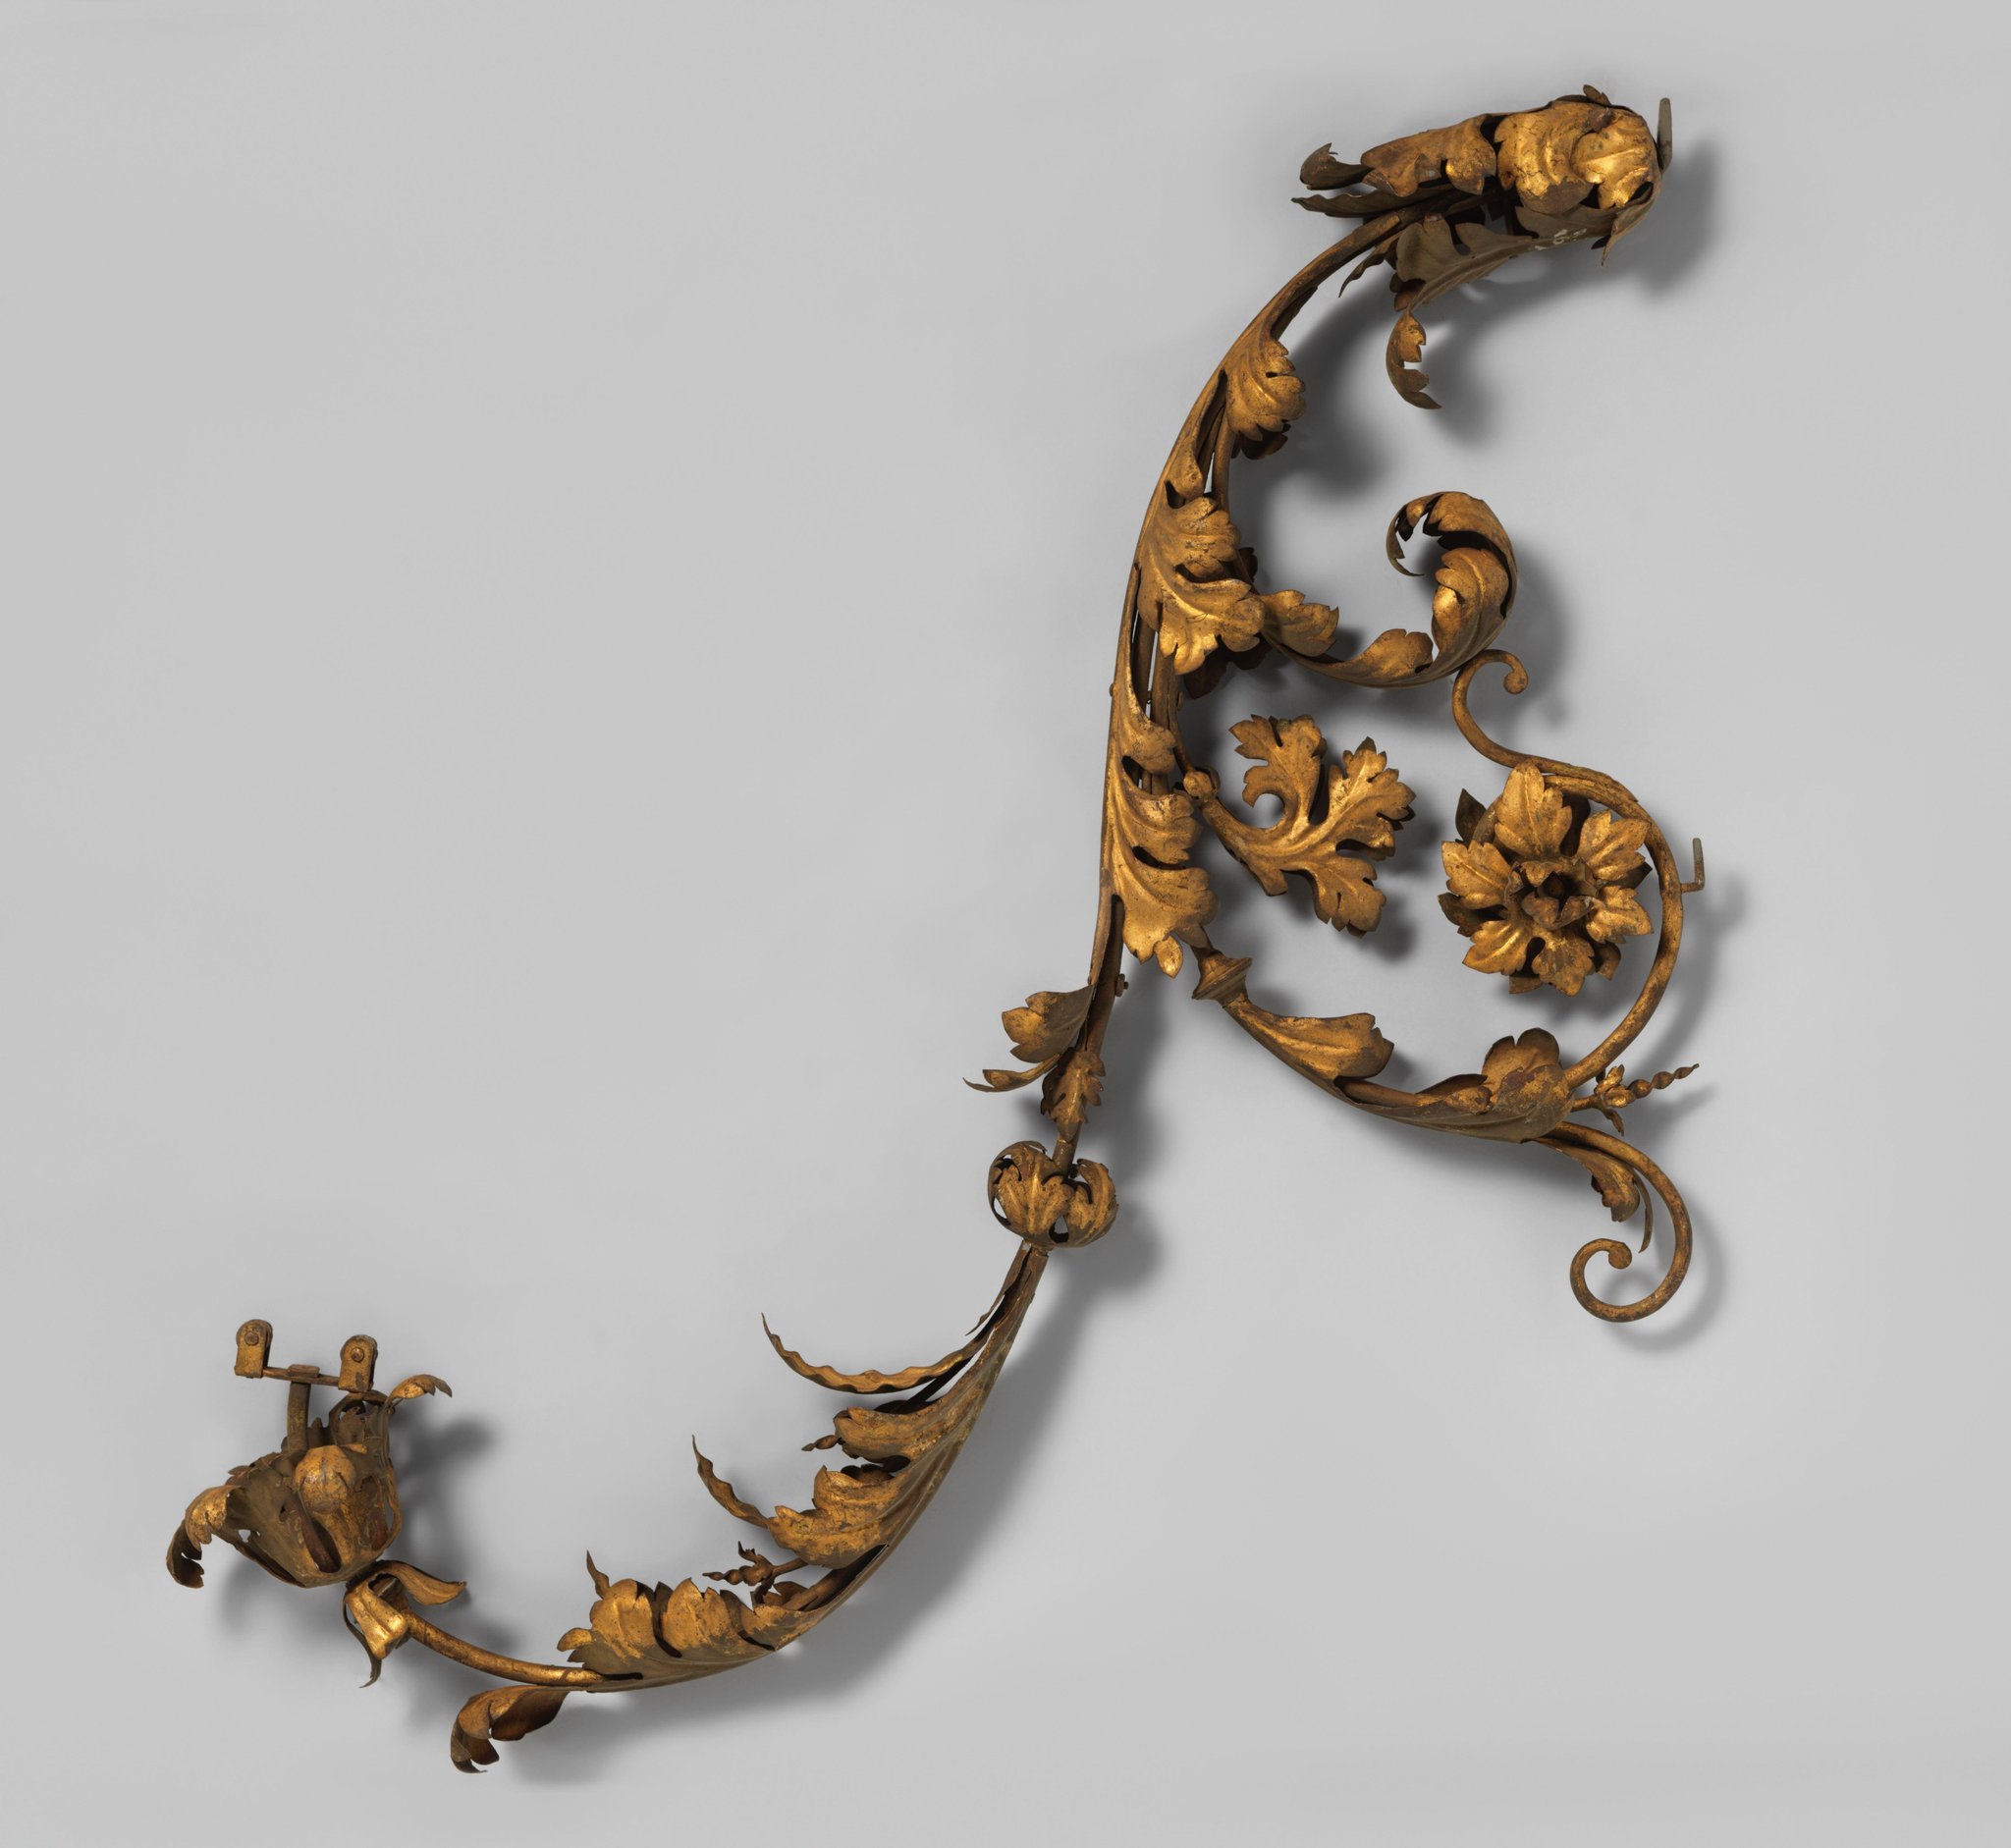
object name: sconce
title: Wandarm van verguld ijzer, uit verz. Mannheimer.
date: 1700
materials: iron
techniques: gilding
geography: venice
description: Een verguld ijzeren wandarm. Gevormd door een lange, naar boven gerichte, met bladeren bezette rank die aan het einde ombuigt en na een nodus in een bloem eindigt. Even onder het midden ontspruit een tweede zich naar de wand buigende rank met voor het midden een schijfvormige nodus. Deze rank met terugbuigend zijrank, is bezet met bladeren en eindigt in een bloem. Afkomstig uit de verzameling Dr. F. Mannheimer.